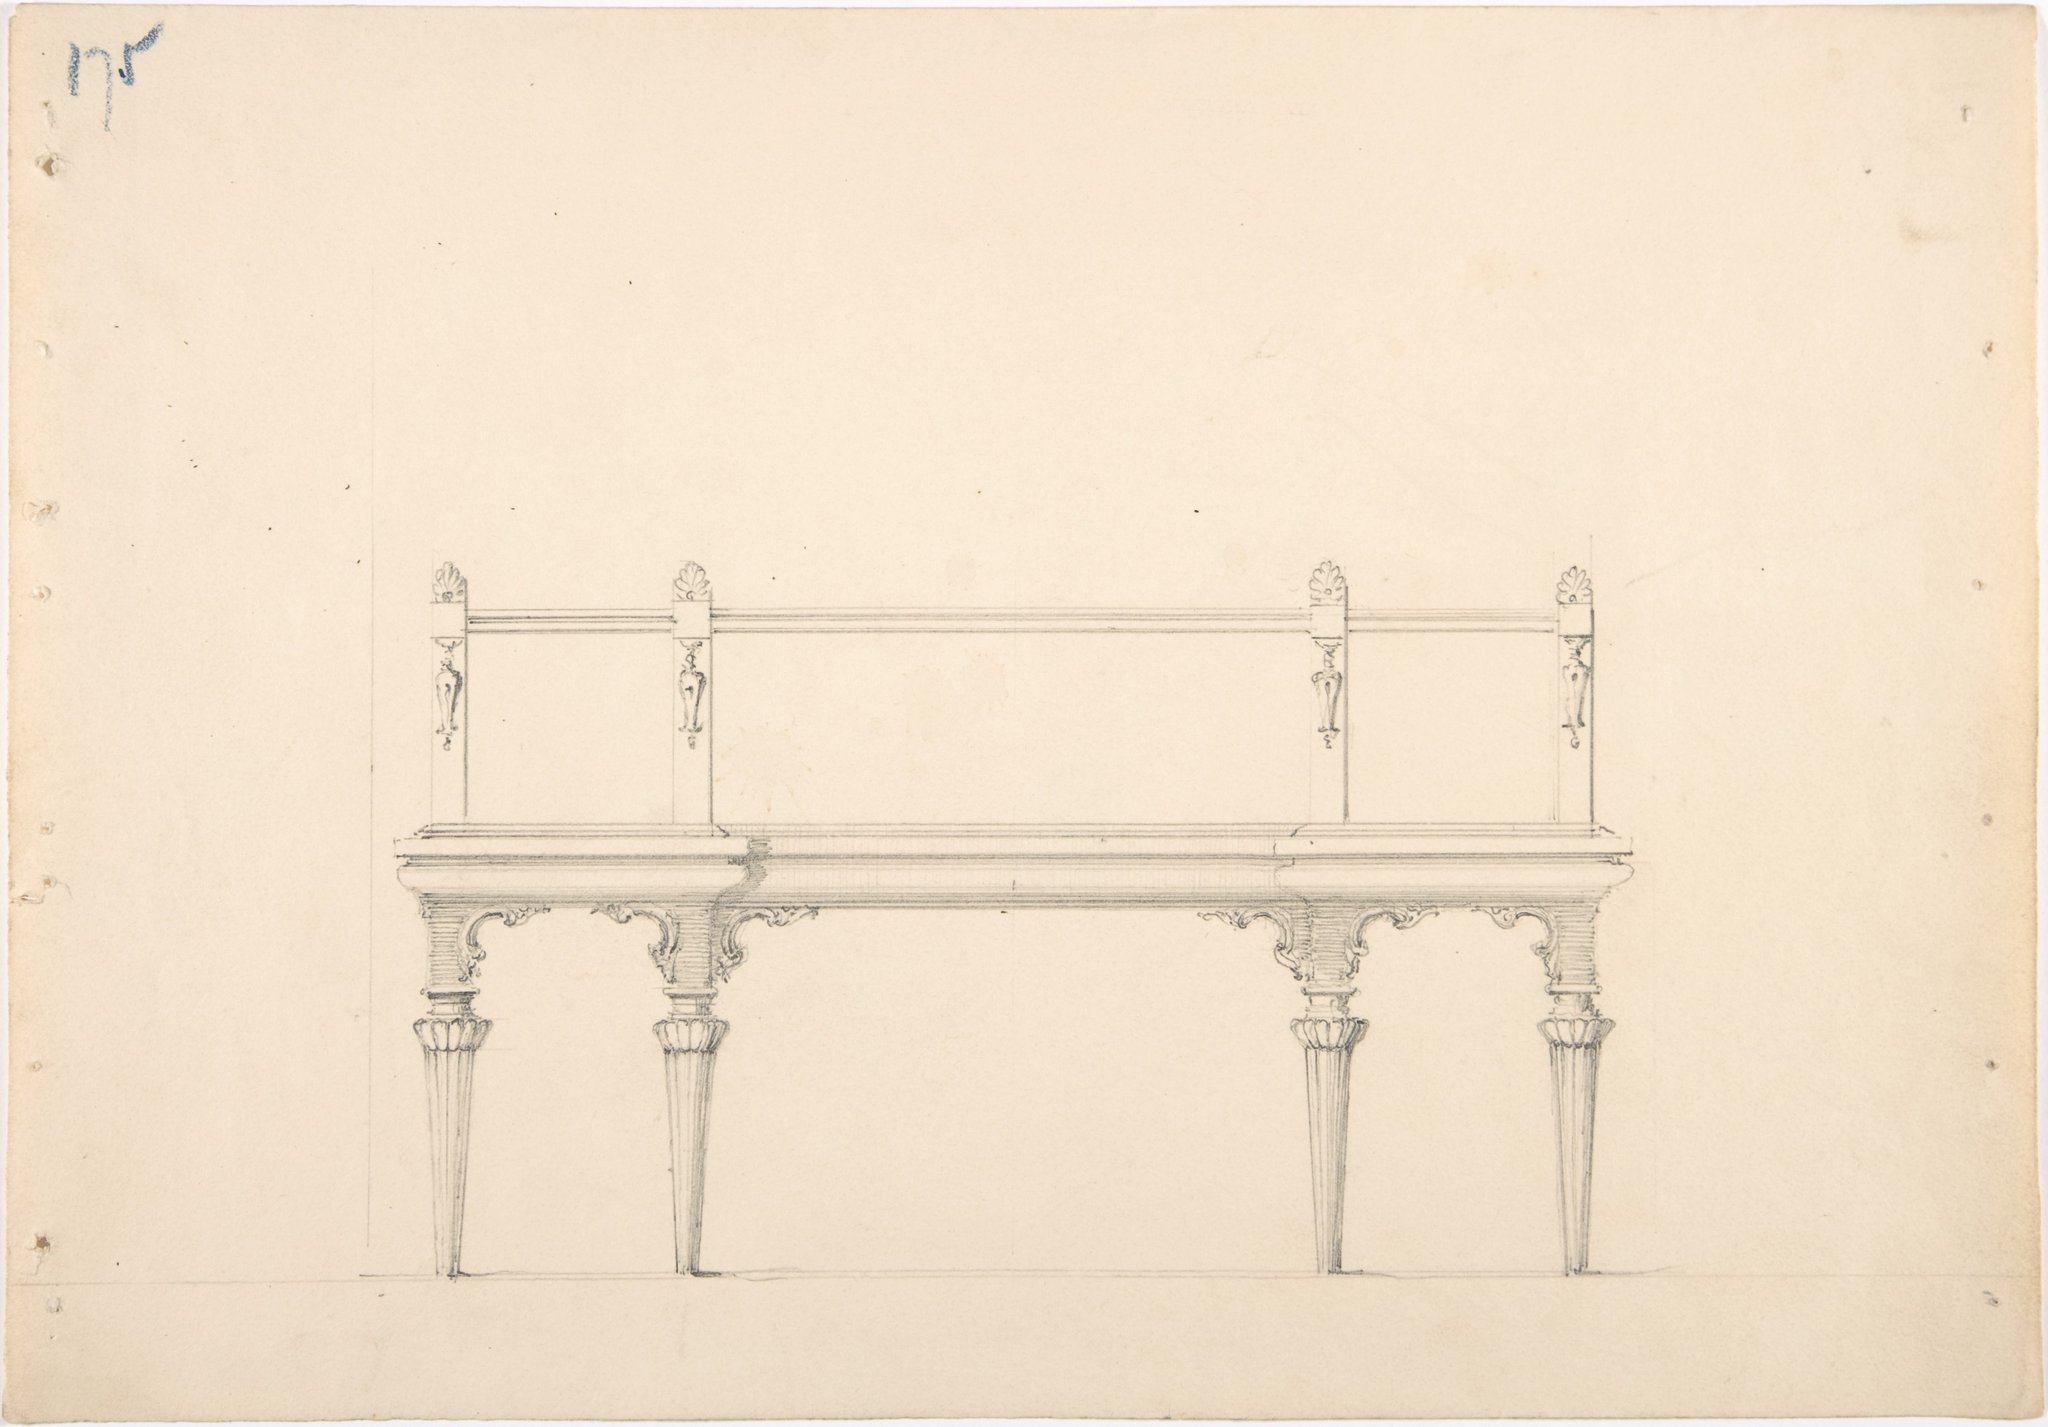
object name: drawing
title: Design for a Mirrored Sideboard with Diminishing Columnar Legs and Classical Ornament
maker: anonymous, british, 19th century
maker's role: artist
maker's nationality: british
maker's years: 1800-1900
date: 1801-1833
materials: graphite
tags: furniture,mirrors